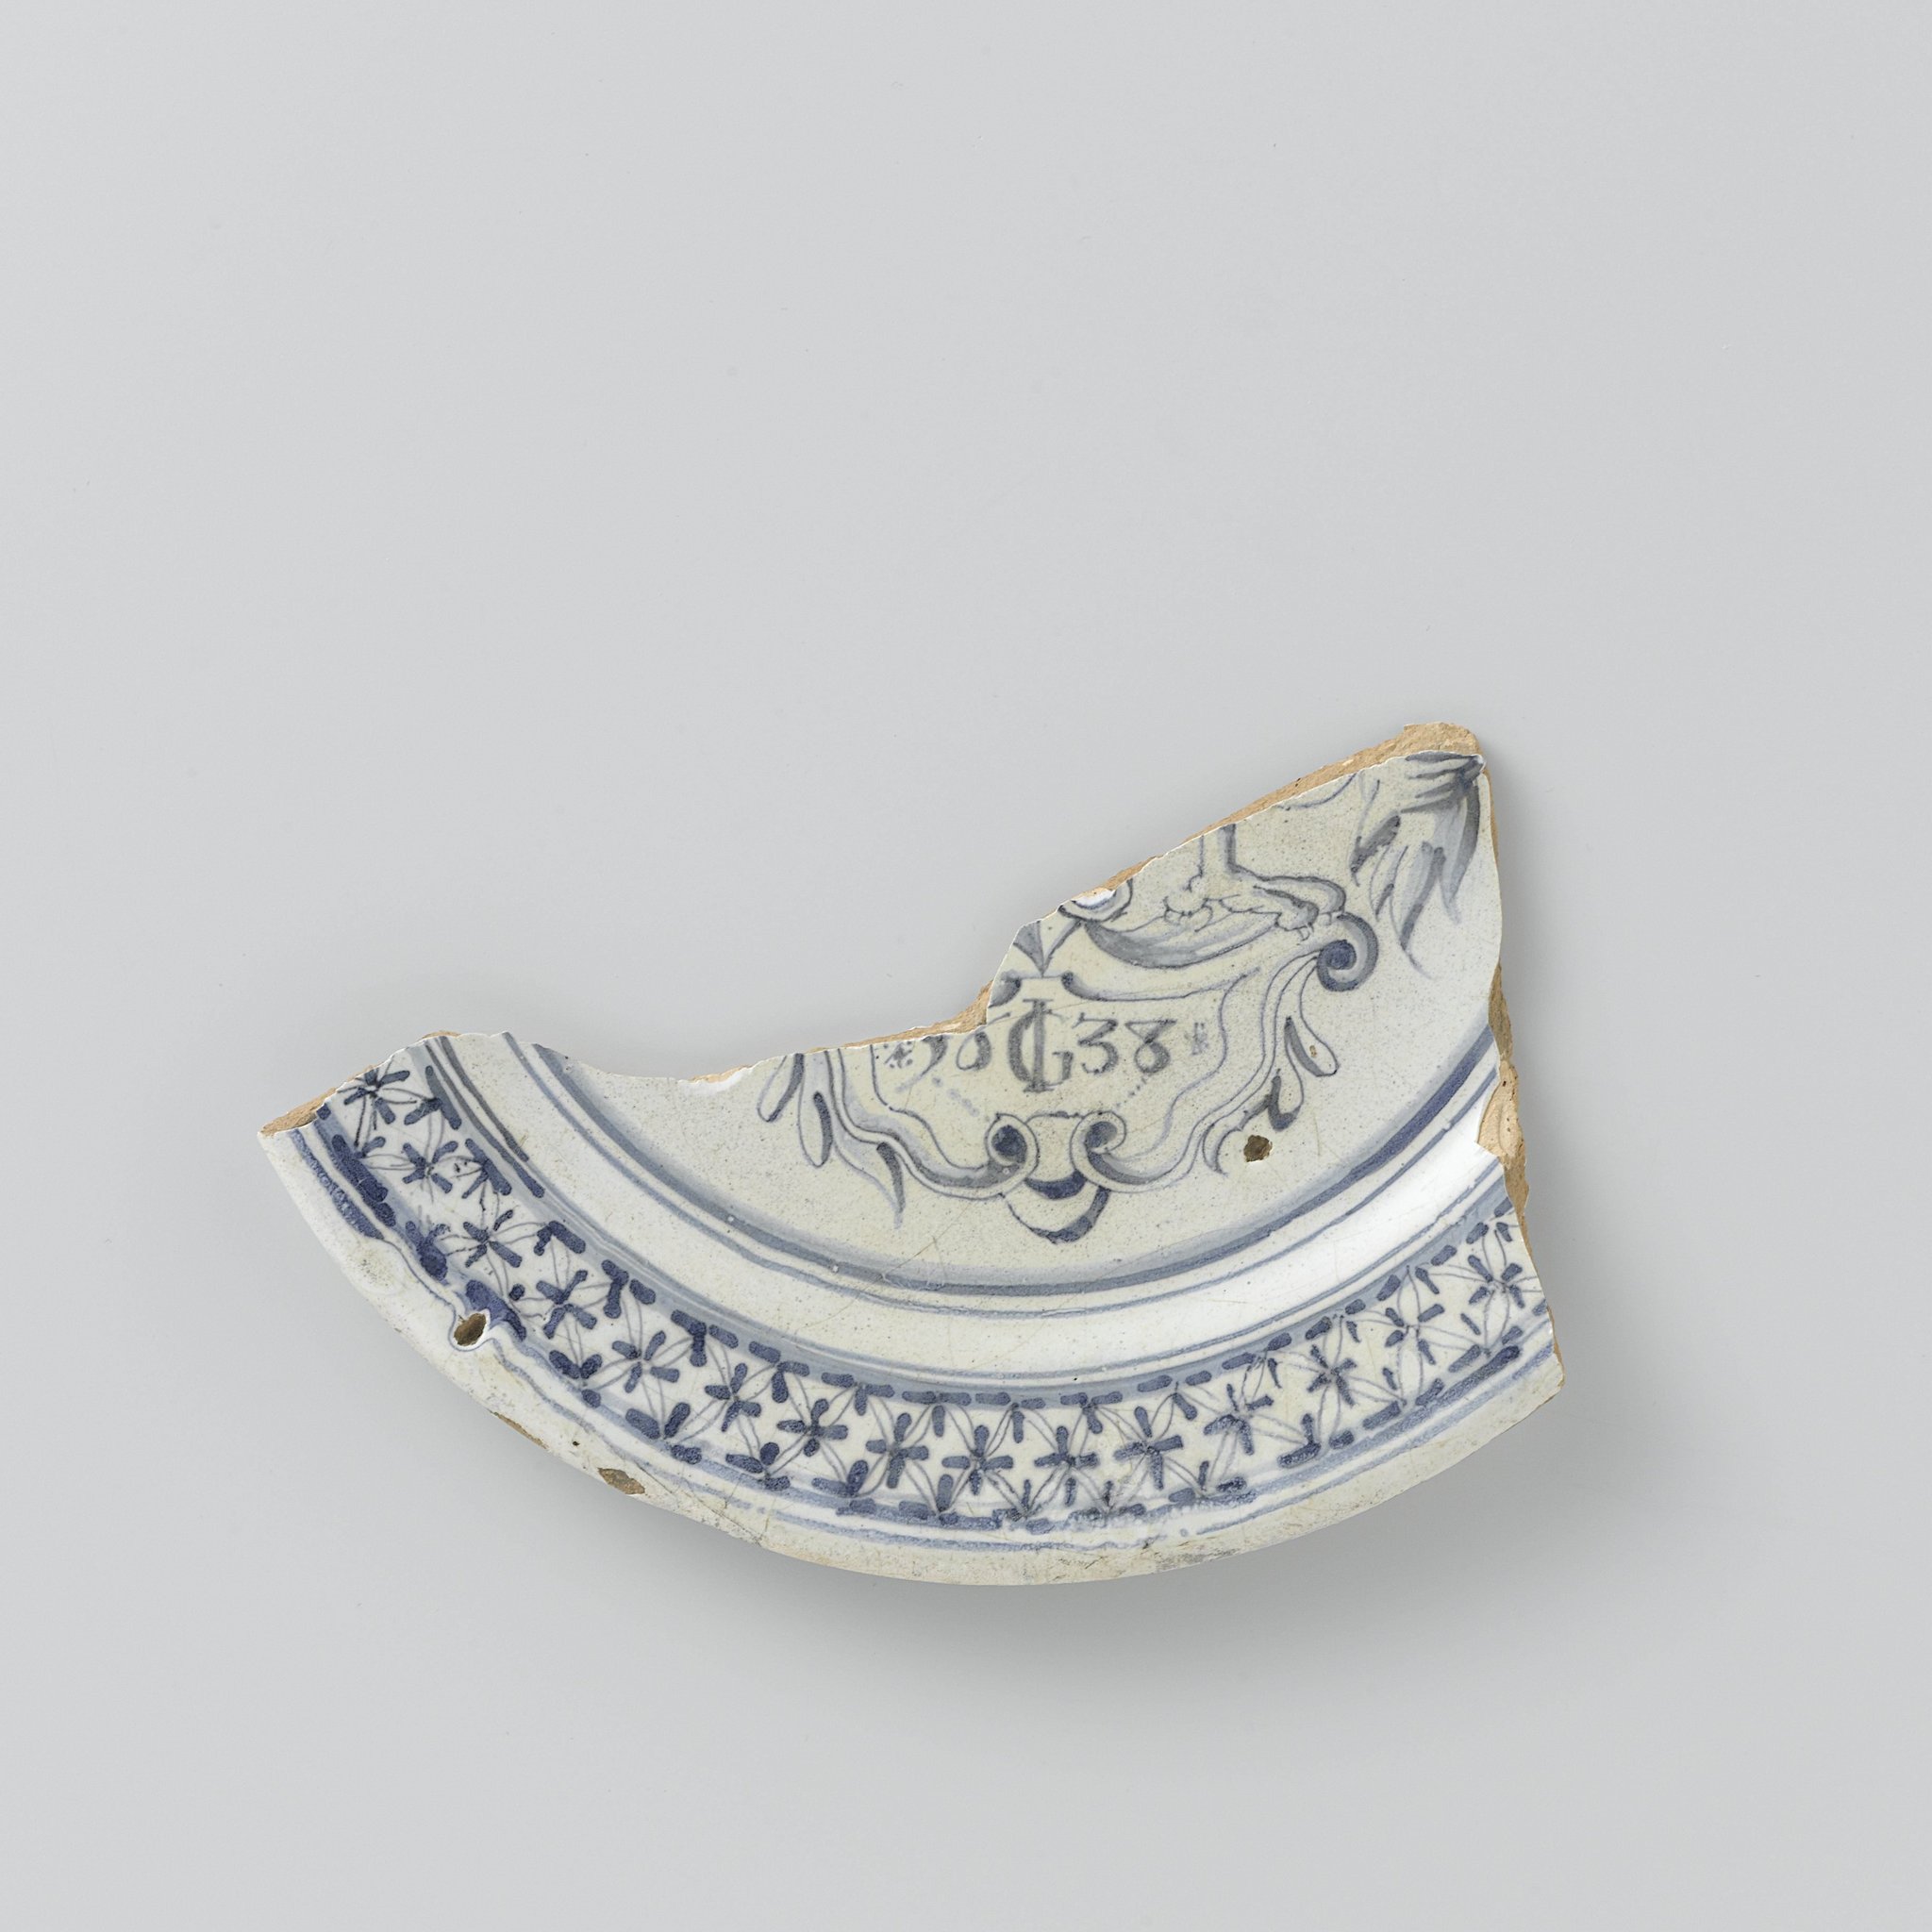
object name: plate dish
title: Fragment van een bord, in blauw beschilderd onder het glazuur met een cartouche met het monogram IG en het jaartal 1638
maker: Anonymous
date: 1638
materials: earthenware, glaze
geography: northern netherlands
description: Fragment van een bord van aardewerk in blauw beschilderd onder het glazuur met een cartouche met het monogram IG en het jaartal 1638.